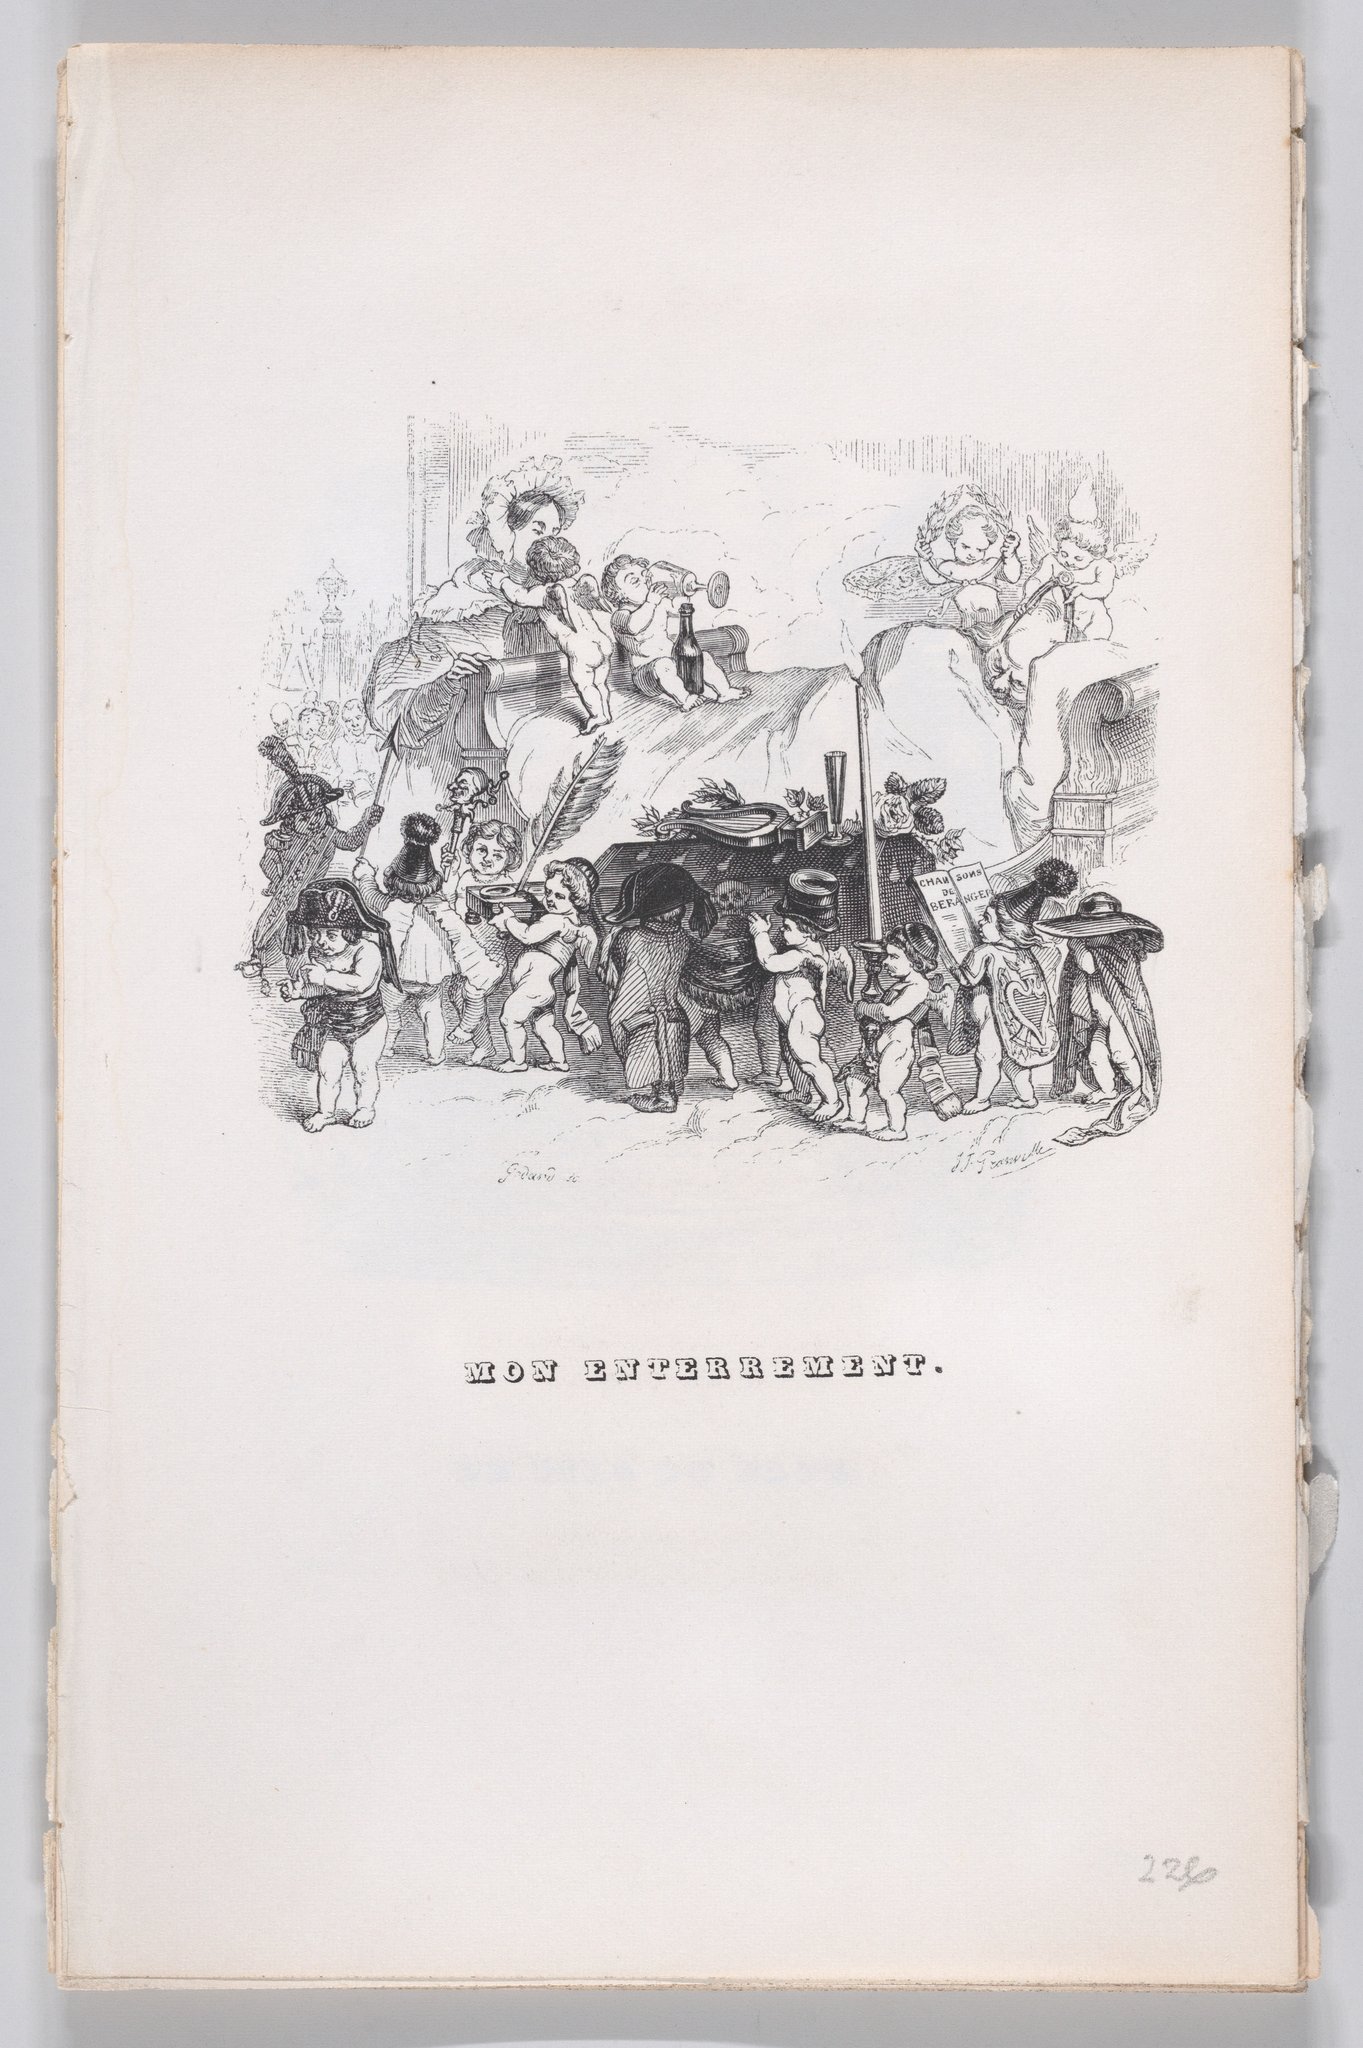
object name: print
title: My Burial, from "The Complete Works of Béranger"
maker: j. j. grandville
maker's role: illustrator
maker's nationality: french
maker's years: 1803-1847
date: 1836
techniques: engraving